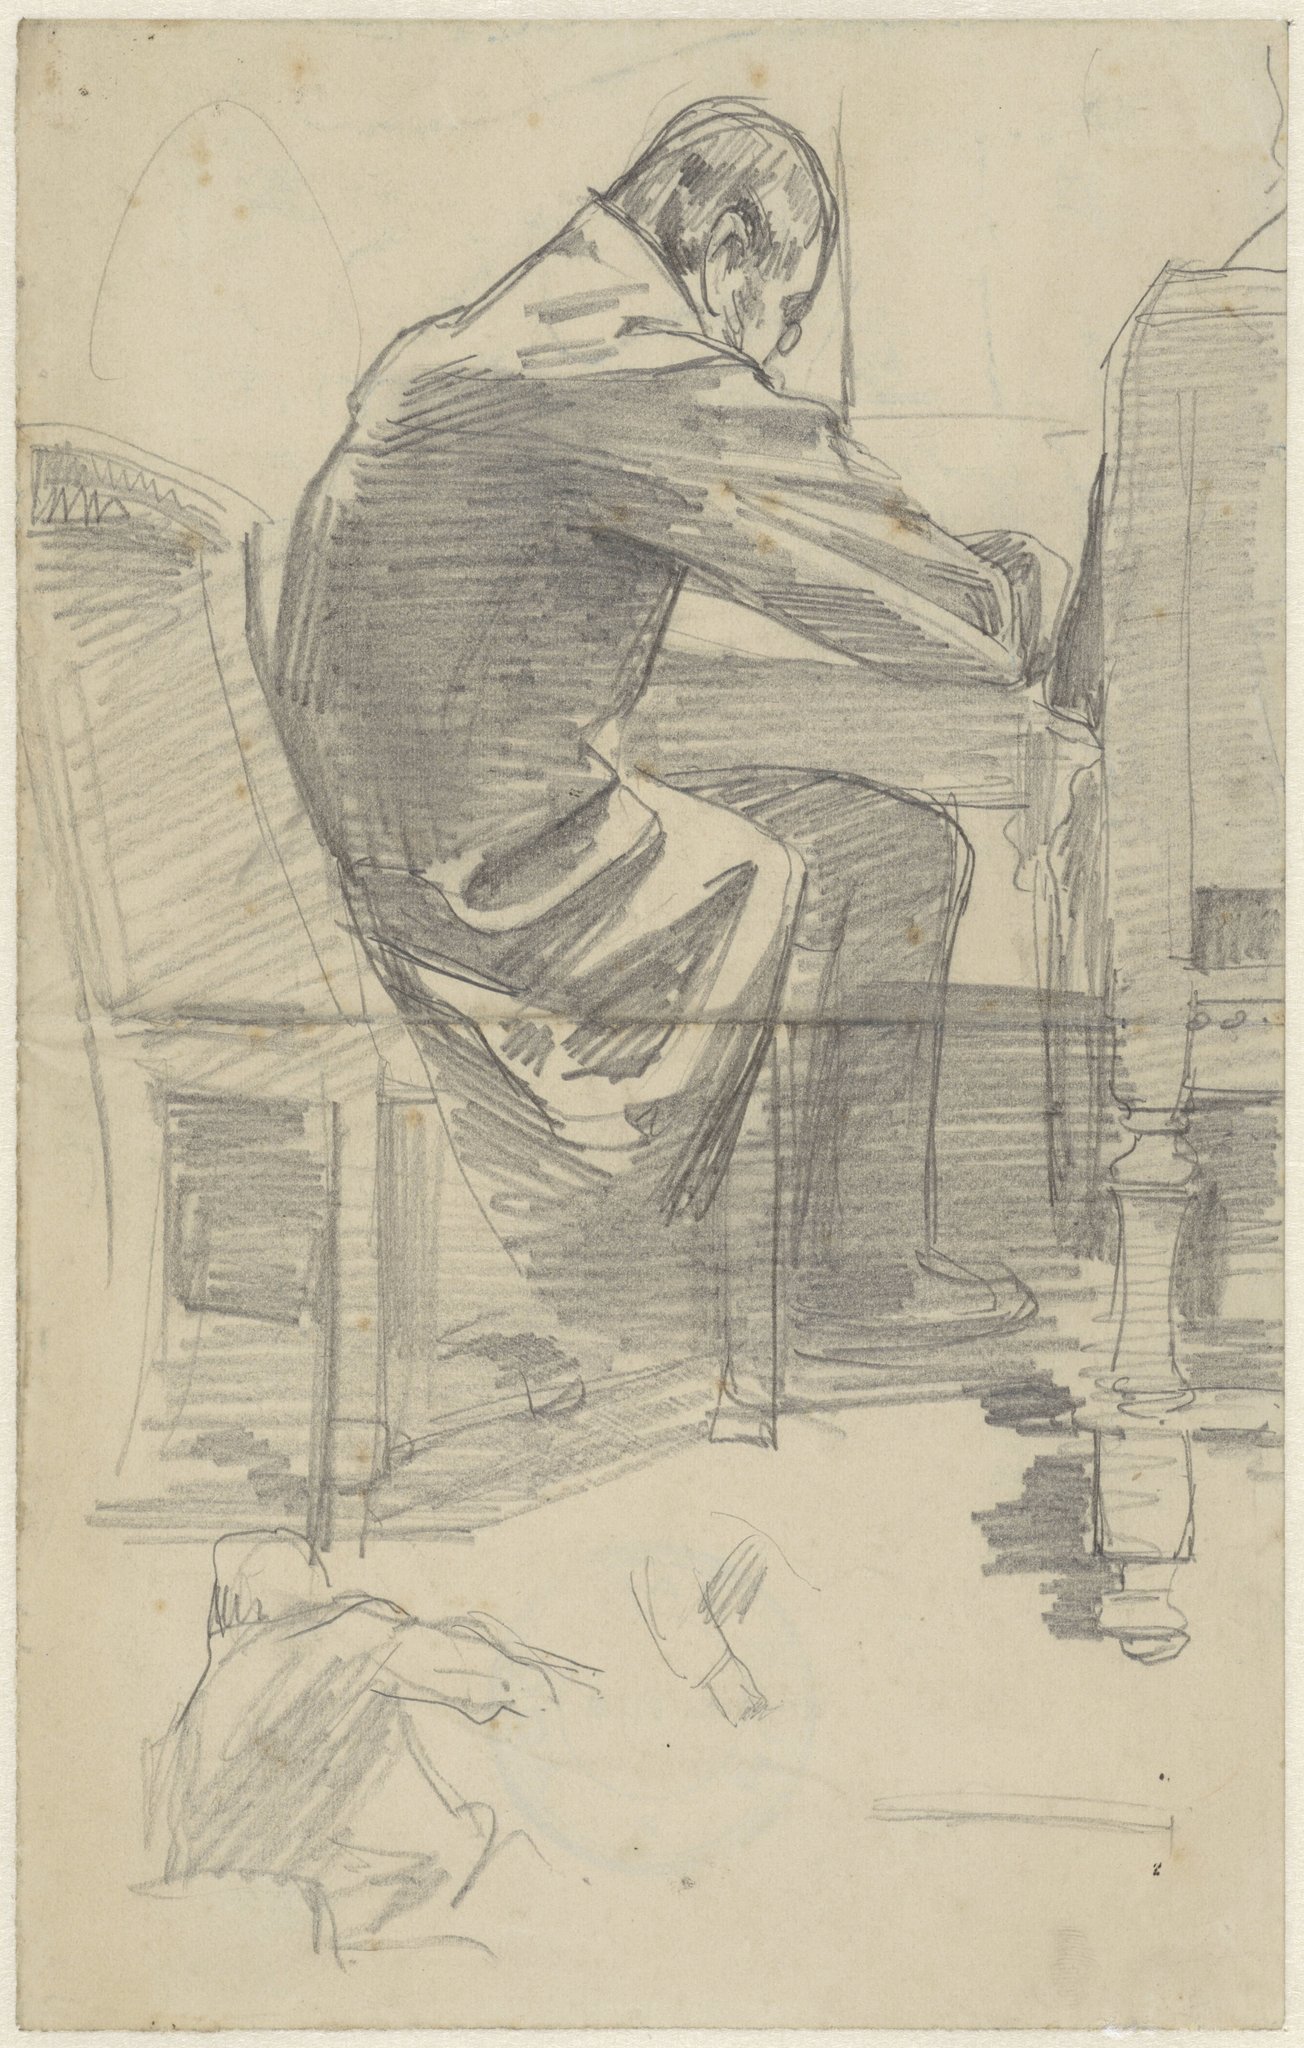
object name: drawing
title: Zittende man aan een tafel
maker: jac van looij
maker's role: draughtsman, painter, print maker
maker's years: 1855-1930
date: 1865-1930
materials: paper, pencil